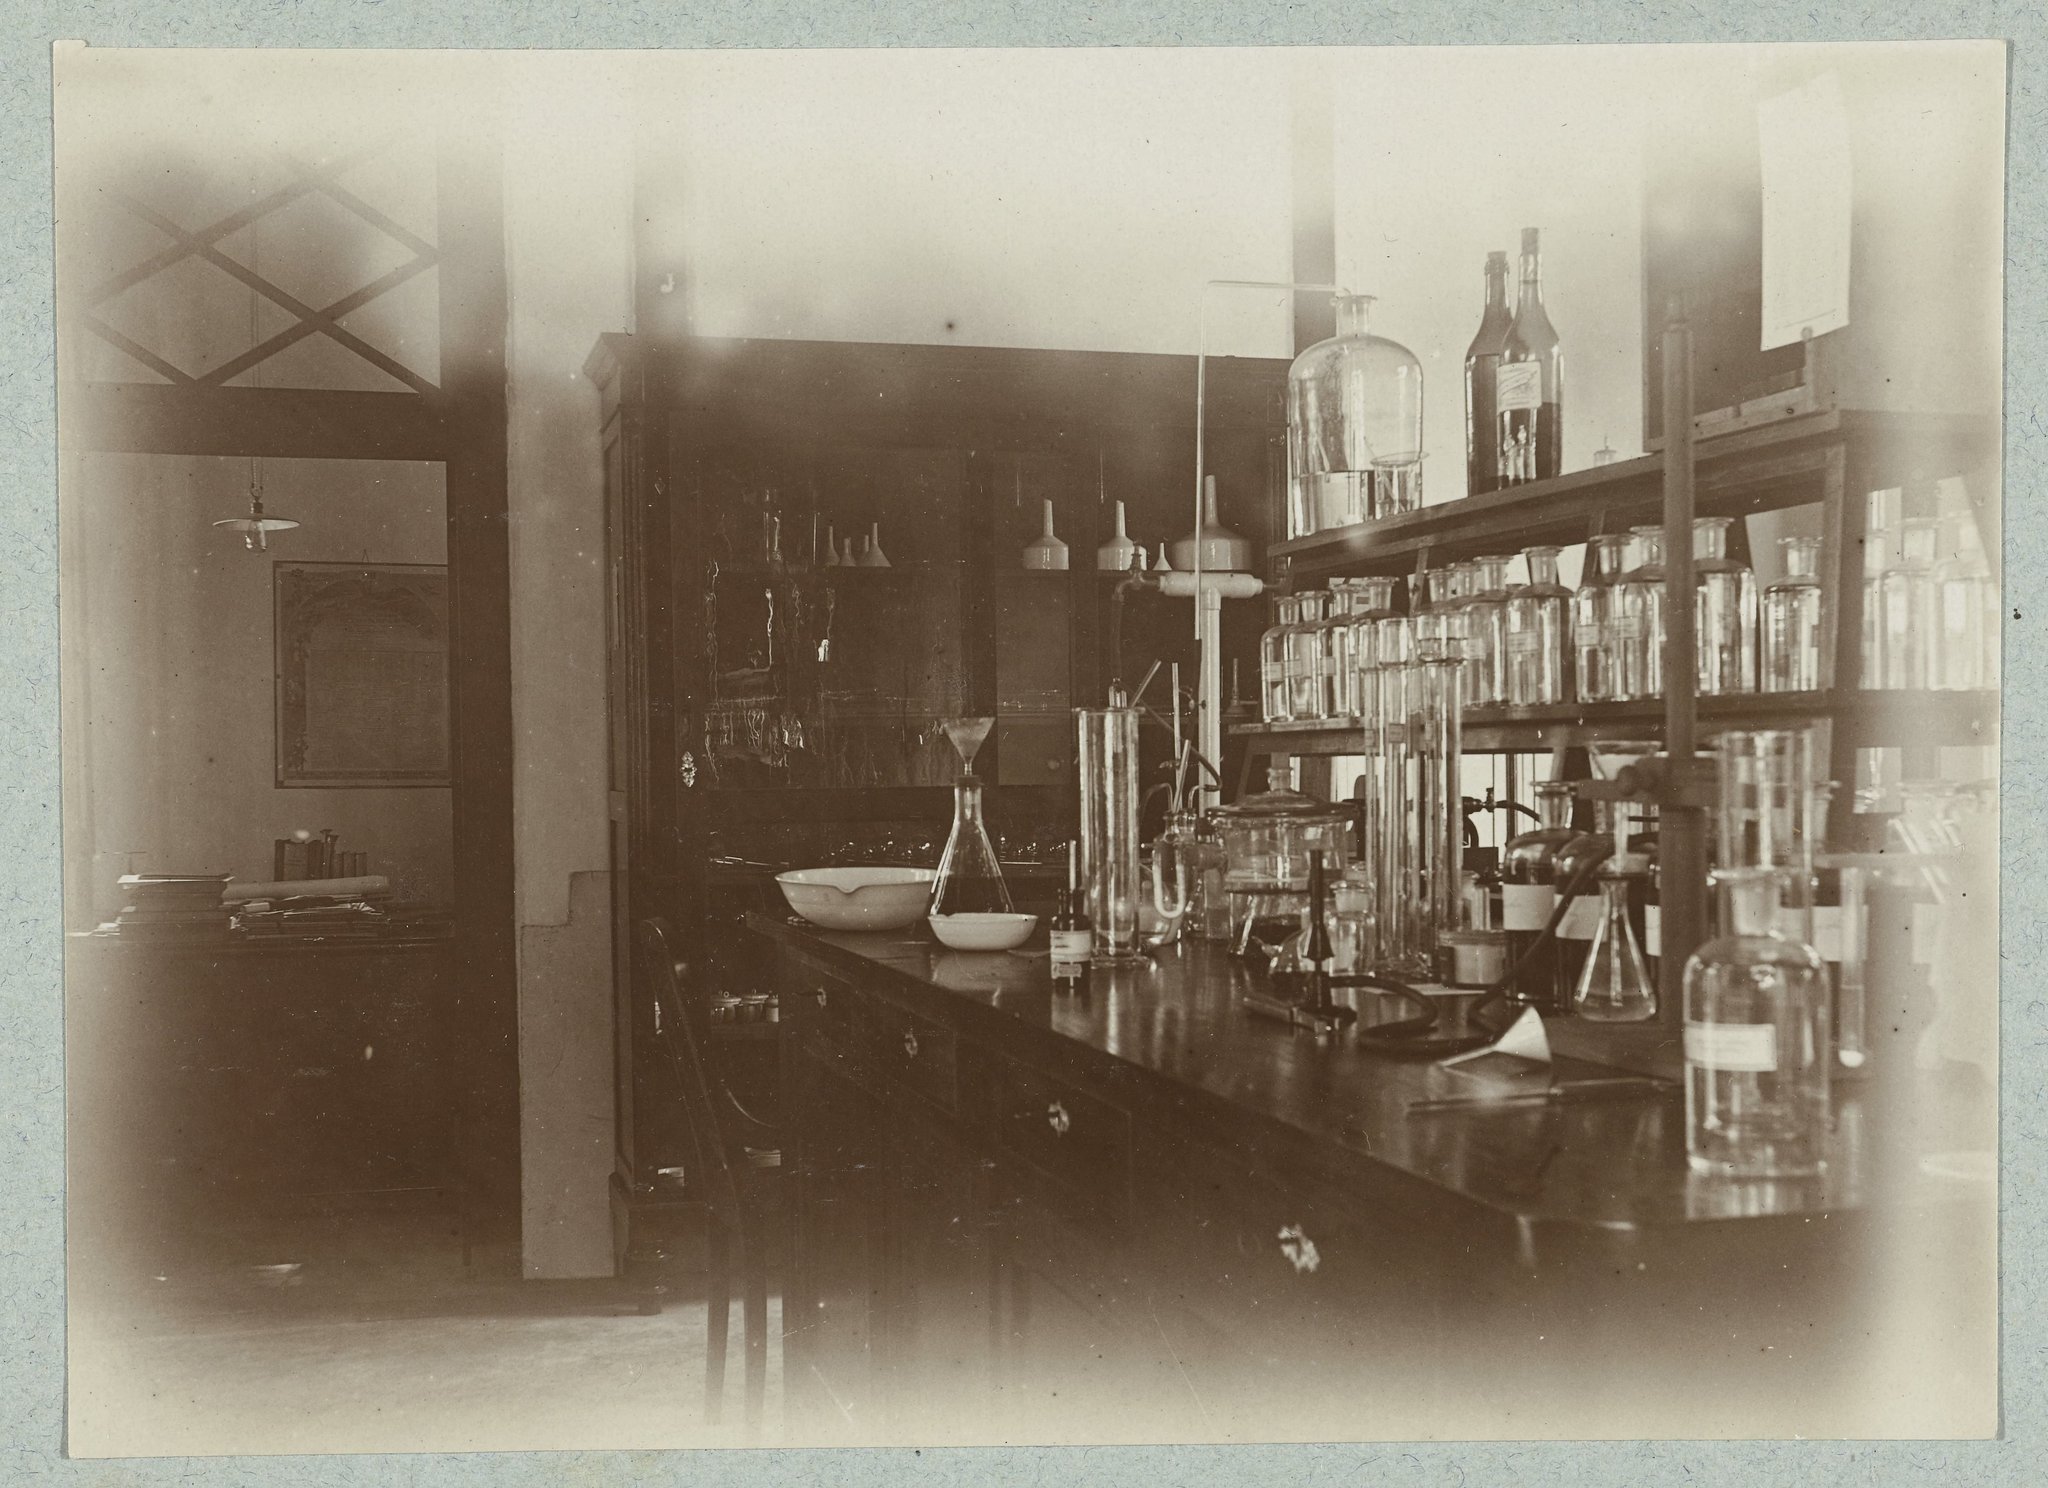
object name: photograph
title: Het laboratorium van de fabriek op Madura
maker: frits freerks fontein fz.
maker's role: fotograaf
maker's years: 1882-1928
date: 1910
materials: cardboard, paper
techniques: gelatin silver print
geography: netherlands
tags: madura